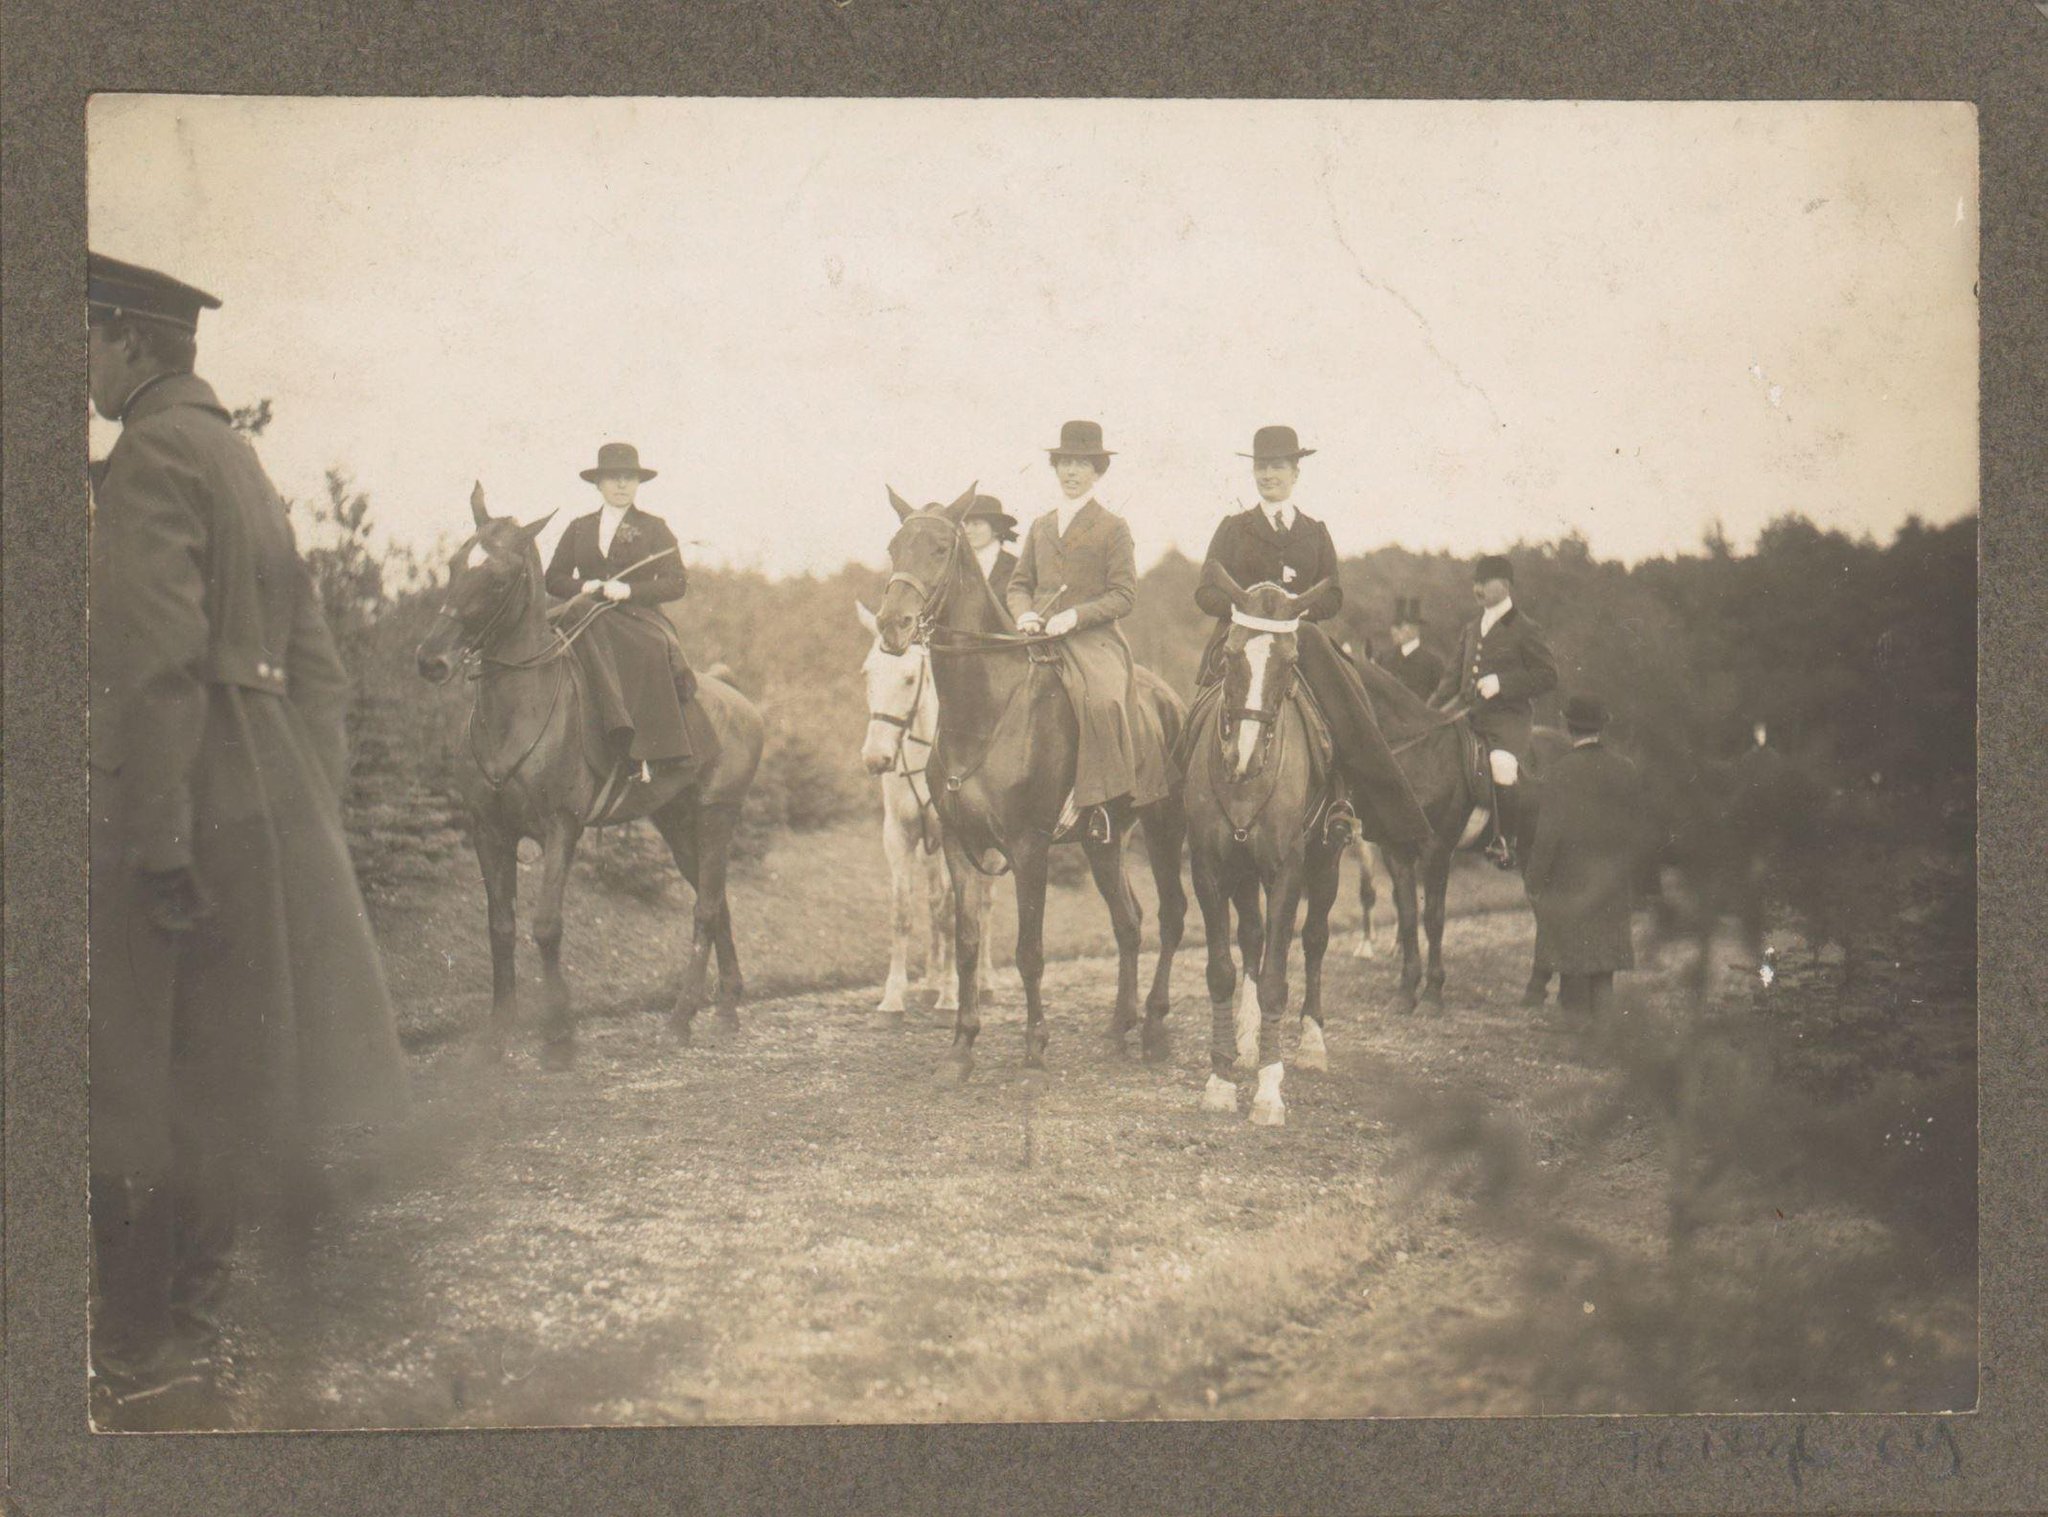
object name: photograph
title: Ruitertafereel op Koninklijke Houtvesterij Het Loo: ruiters waaronder vrouwen in amazonezit op een landweg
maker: Anonymous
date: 1900-1925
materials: photographic support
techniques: gelatin silver print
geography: het loo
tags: riding a horse, ass, or mule; rider, horseman, hunting, chase, hunting-ground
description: Onderdeel van Fotoalbum van de heer Brams, opperhoutvester van koningin Wilhelmina op Koninklijke Houtvesterij Het Loo.